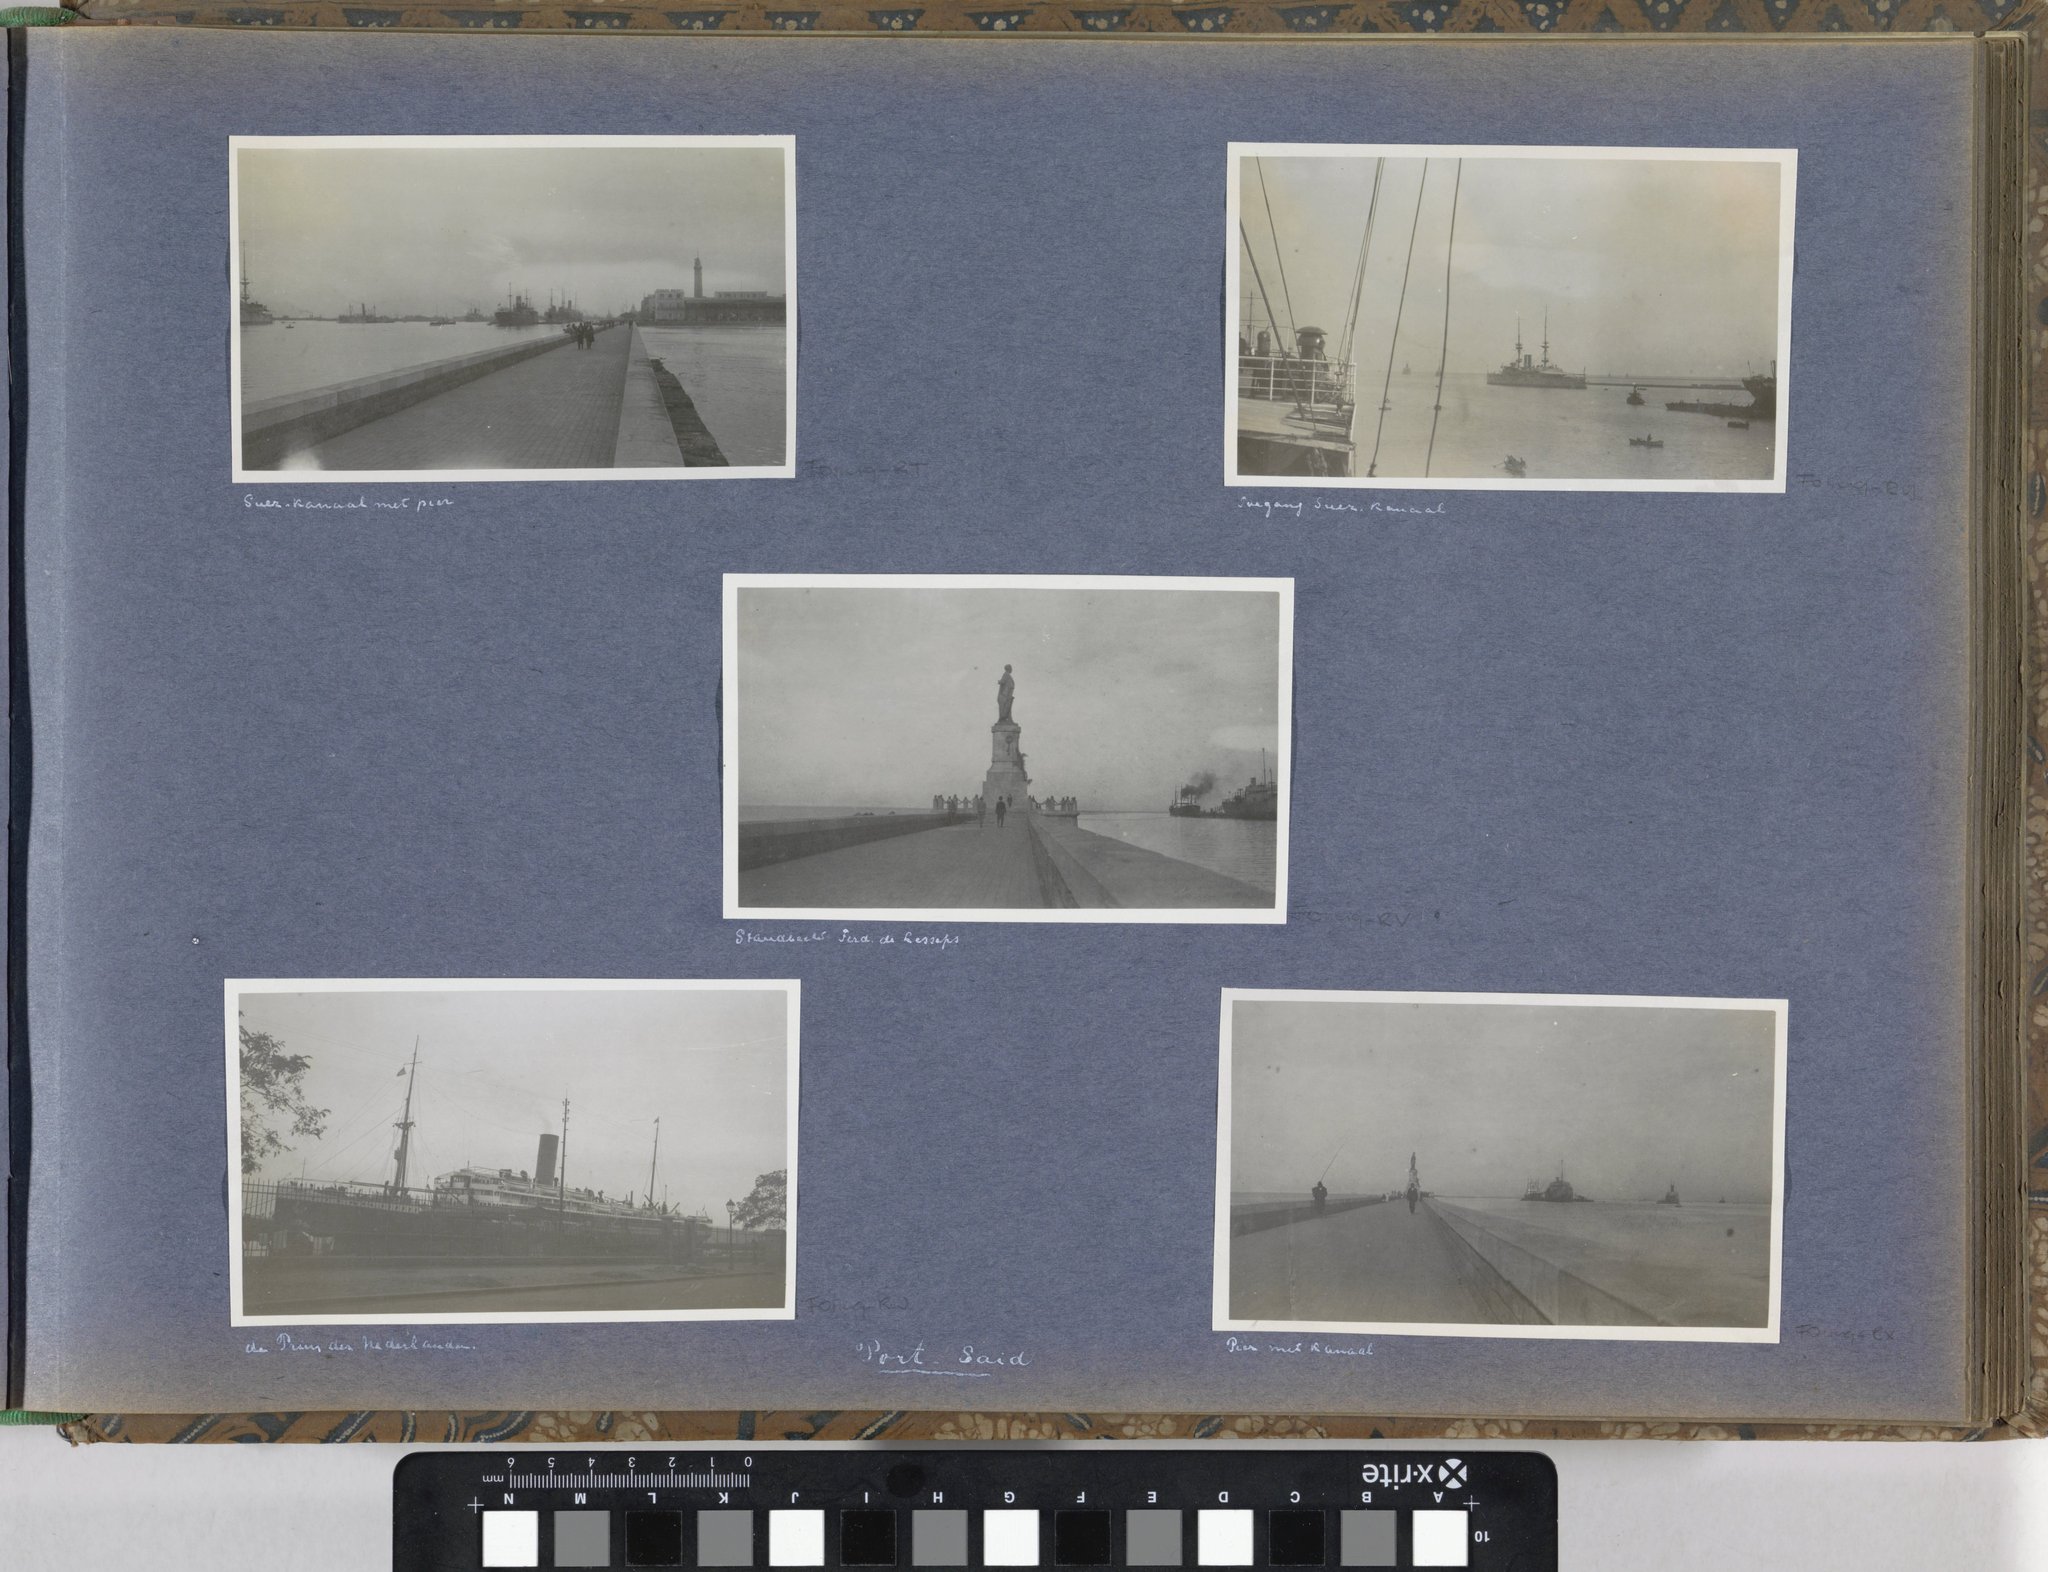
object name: photograph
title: Pier langs het Suezkanaal in Port Said met op de kop het standbeeld van Ferdinand de Lesseps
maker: Anonymous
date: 1900-1920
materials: paper, photographic support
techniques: gelatin silver print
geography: port said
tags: canal, monument, statue, pier, quay, wharf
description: Onderdeel van reisalbum met foto's van bedrijvigheid en bezienswaardigheden op Sumatra en Java en van de reis naar en van Nederlands-Indië.